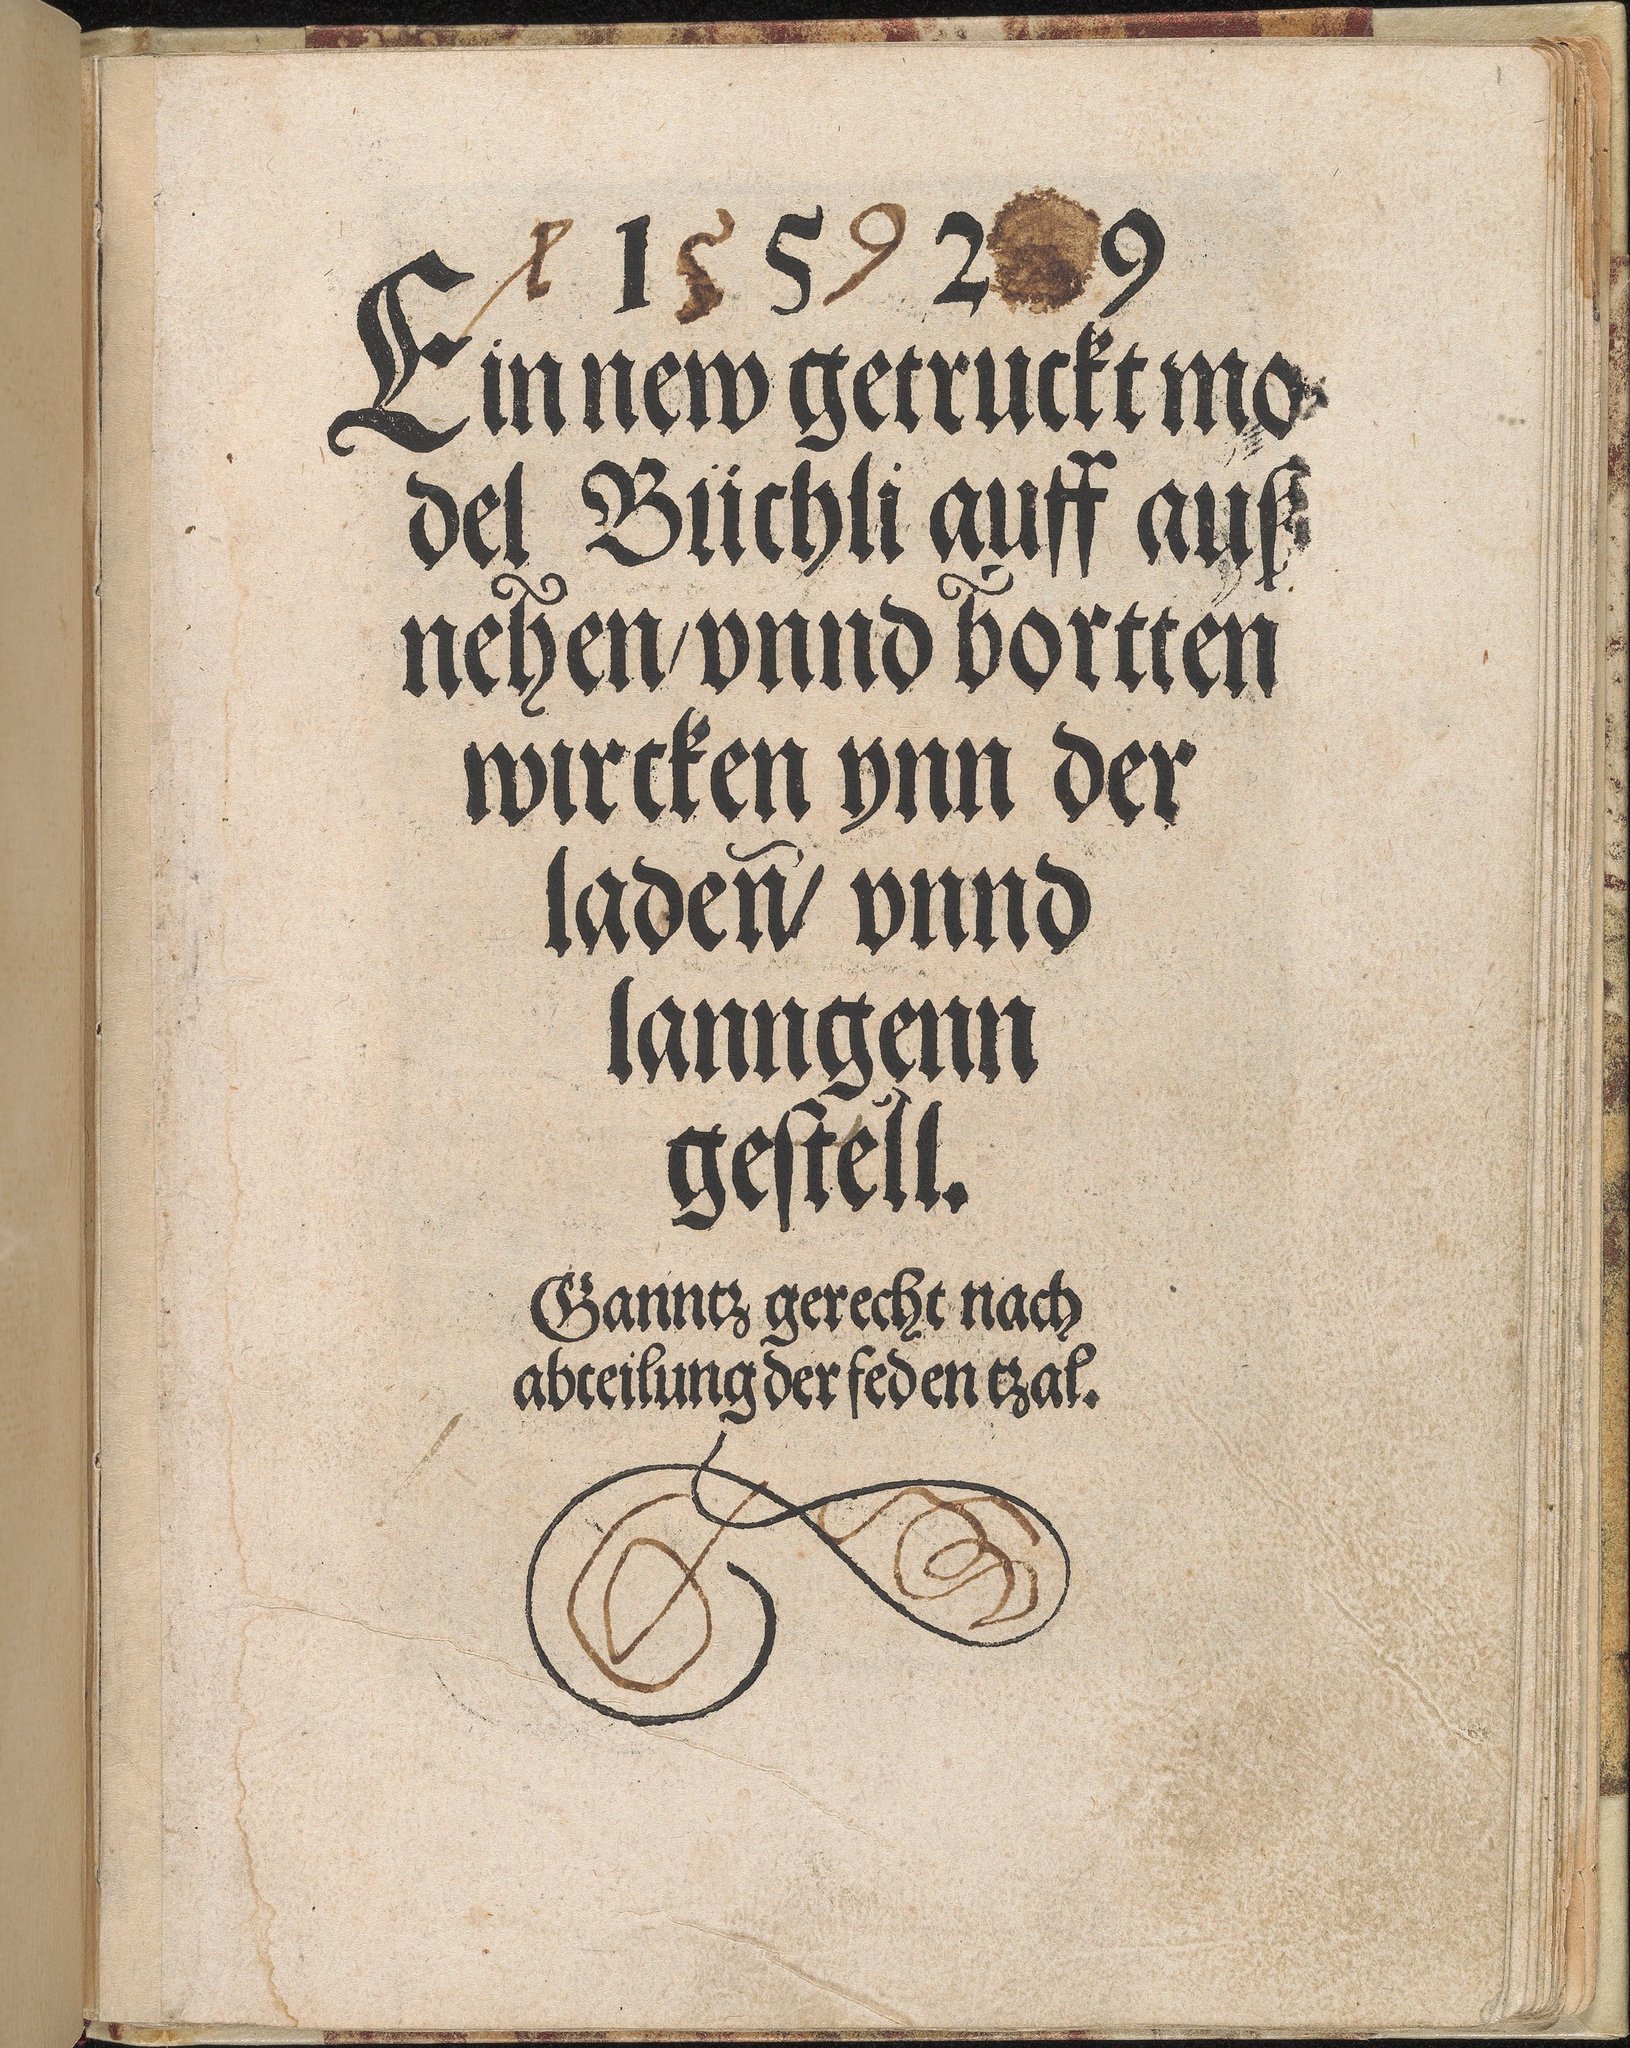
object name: book print ornament architecture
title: Ein new getruckt model Büchli...Title page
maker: johann schönsperger the younger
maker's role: publisher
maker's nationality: german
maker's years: 1490-1550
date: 1529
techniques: woodcut